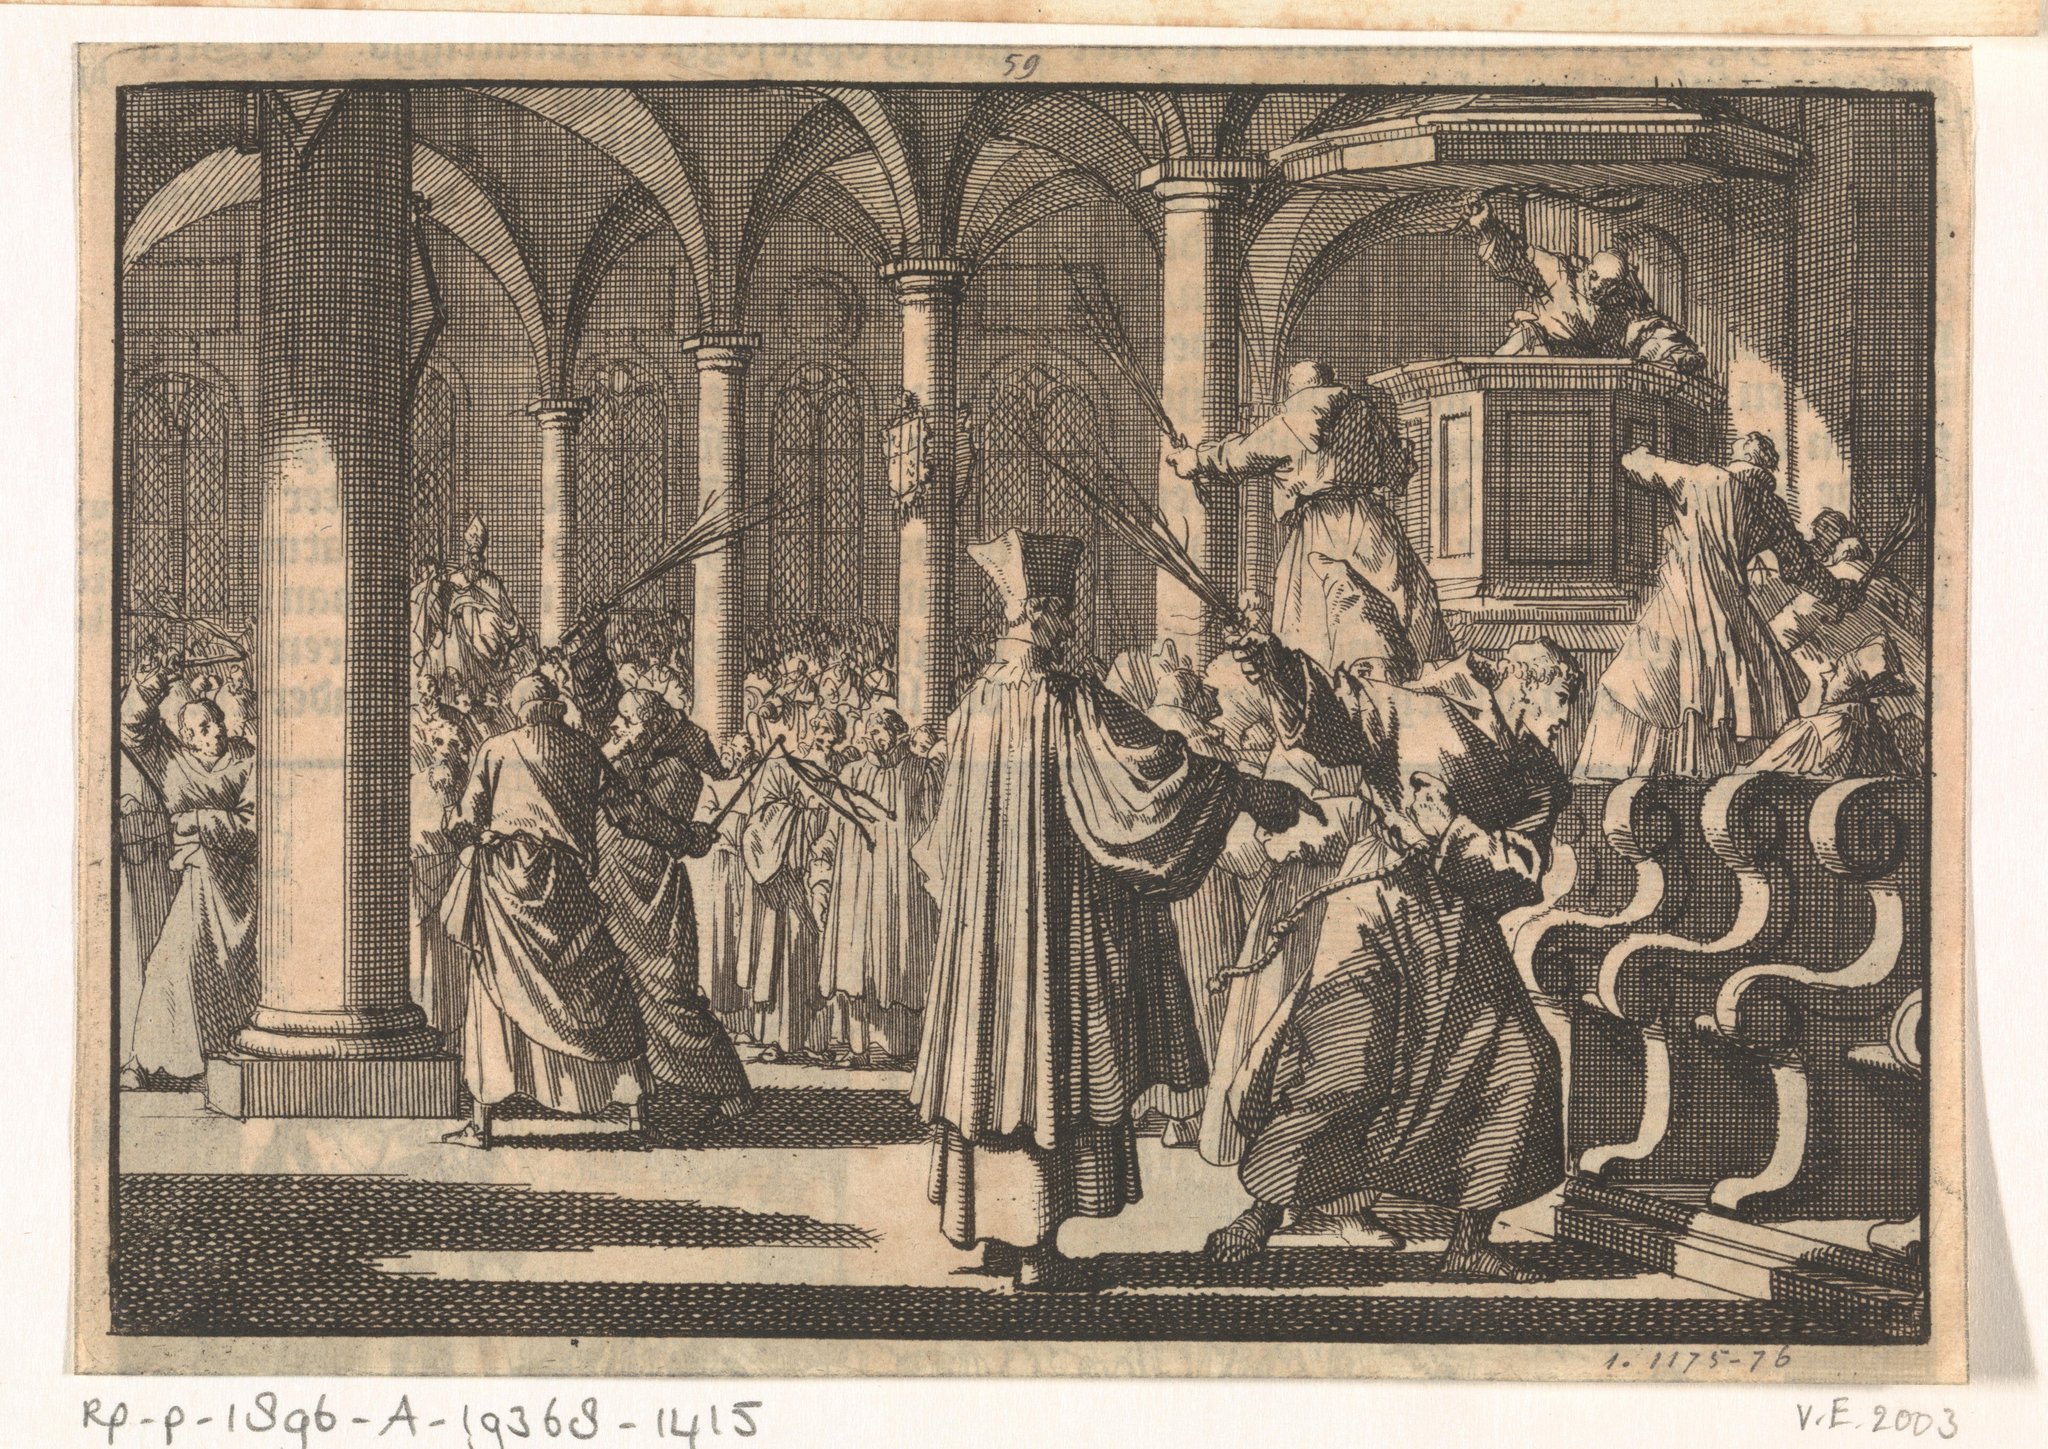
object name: book illustration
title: Margarethakerk te La Rochelle wordt opnieuw katholiek gewijd door preekstoel, pilaren en banken met roeden te geselen, 1628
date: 1698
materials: paper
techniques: etching, letterpress printing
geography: amsterdam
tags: ritual consecration ~ christian religion, interior of church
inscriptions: collector's mark: Lugt 2228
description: Illustratie uit: Gottfried, Johann Ludwig. Historische kronyck; vervattende een (...) beschrijvingh der aldergedenckwaerdigste geschiedenissen des weerelds, van den aenvangh der scheppingh tot (...) 1576 (2 delen). Leiden: Pieter van der Aa, 1698, dl. I, p. 1175.